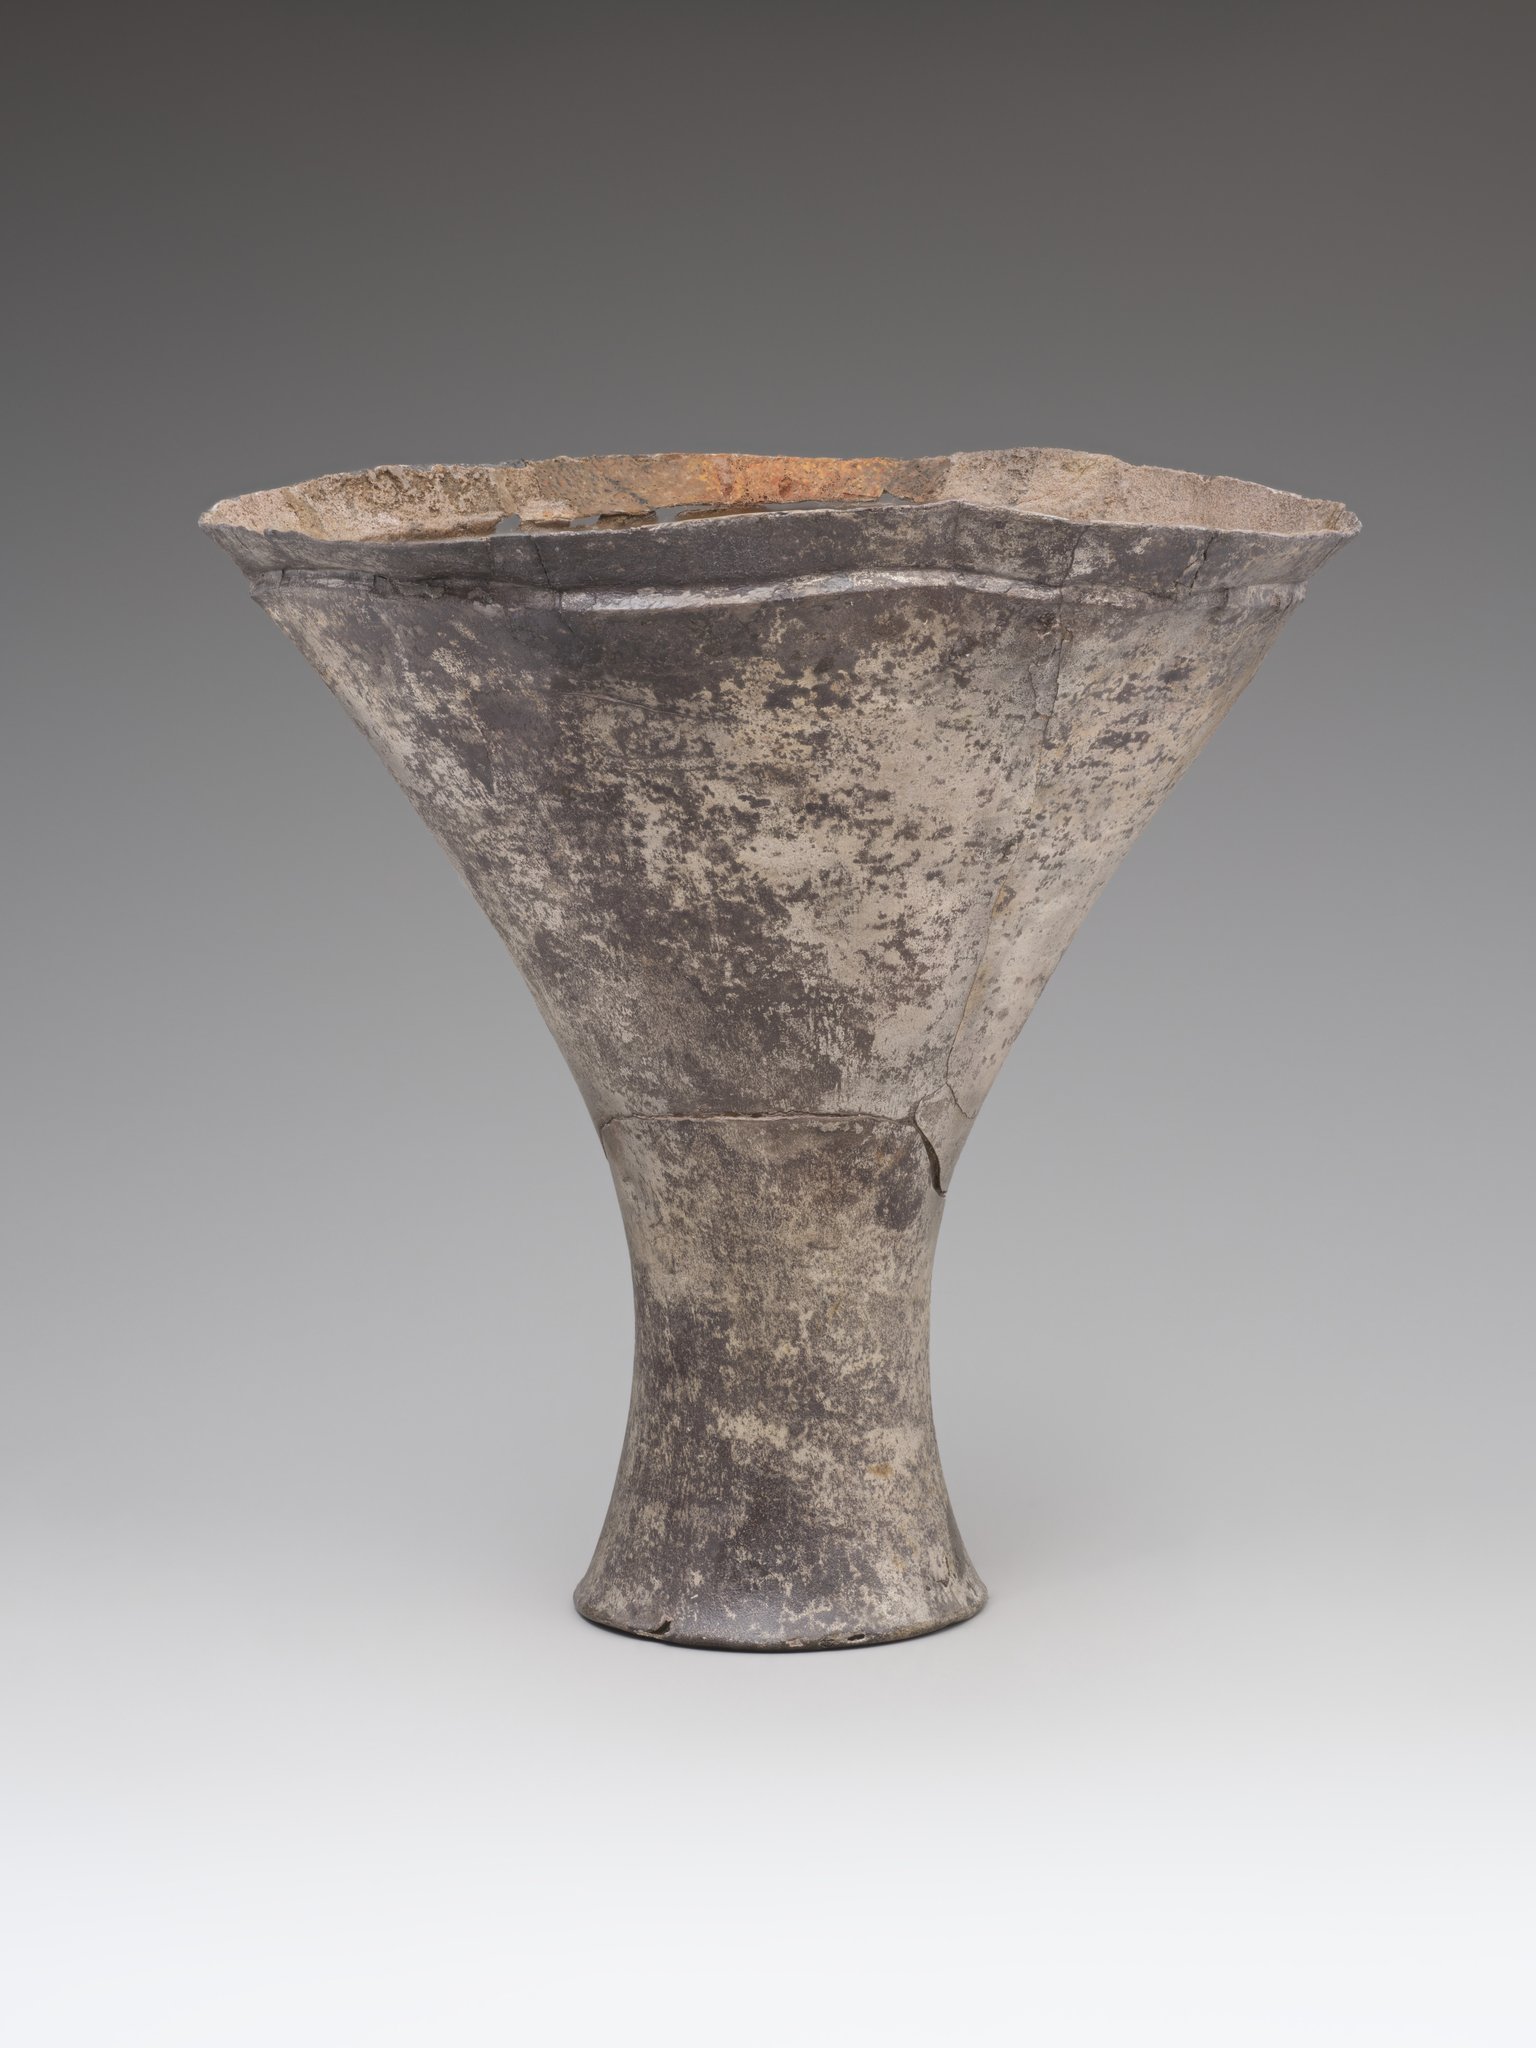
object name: vessel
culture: bactria-margiana archaeological complex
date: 2333-1668 BCE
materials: silver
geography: bactria-margiana